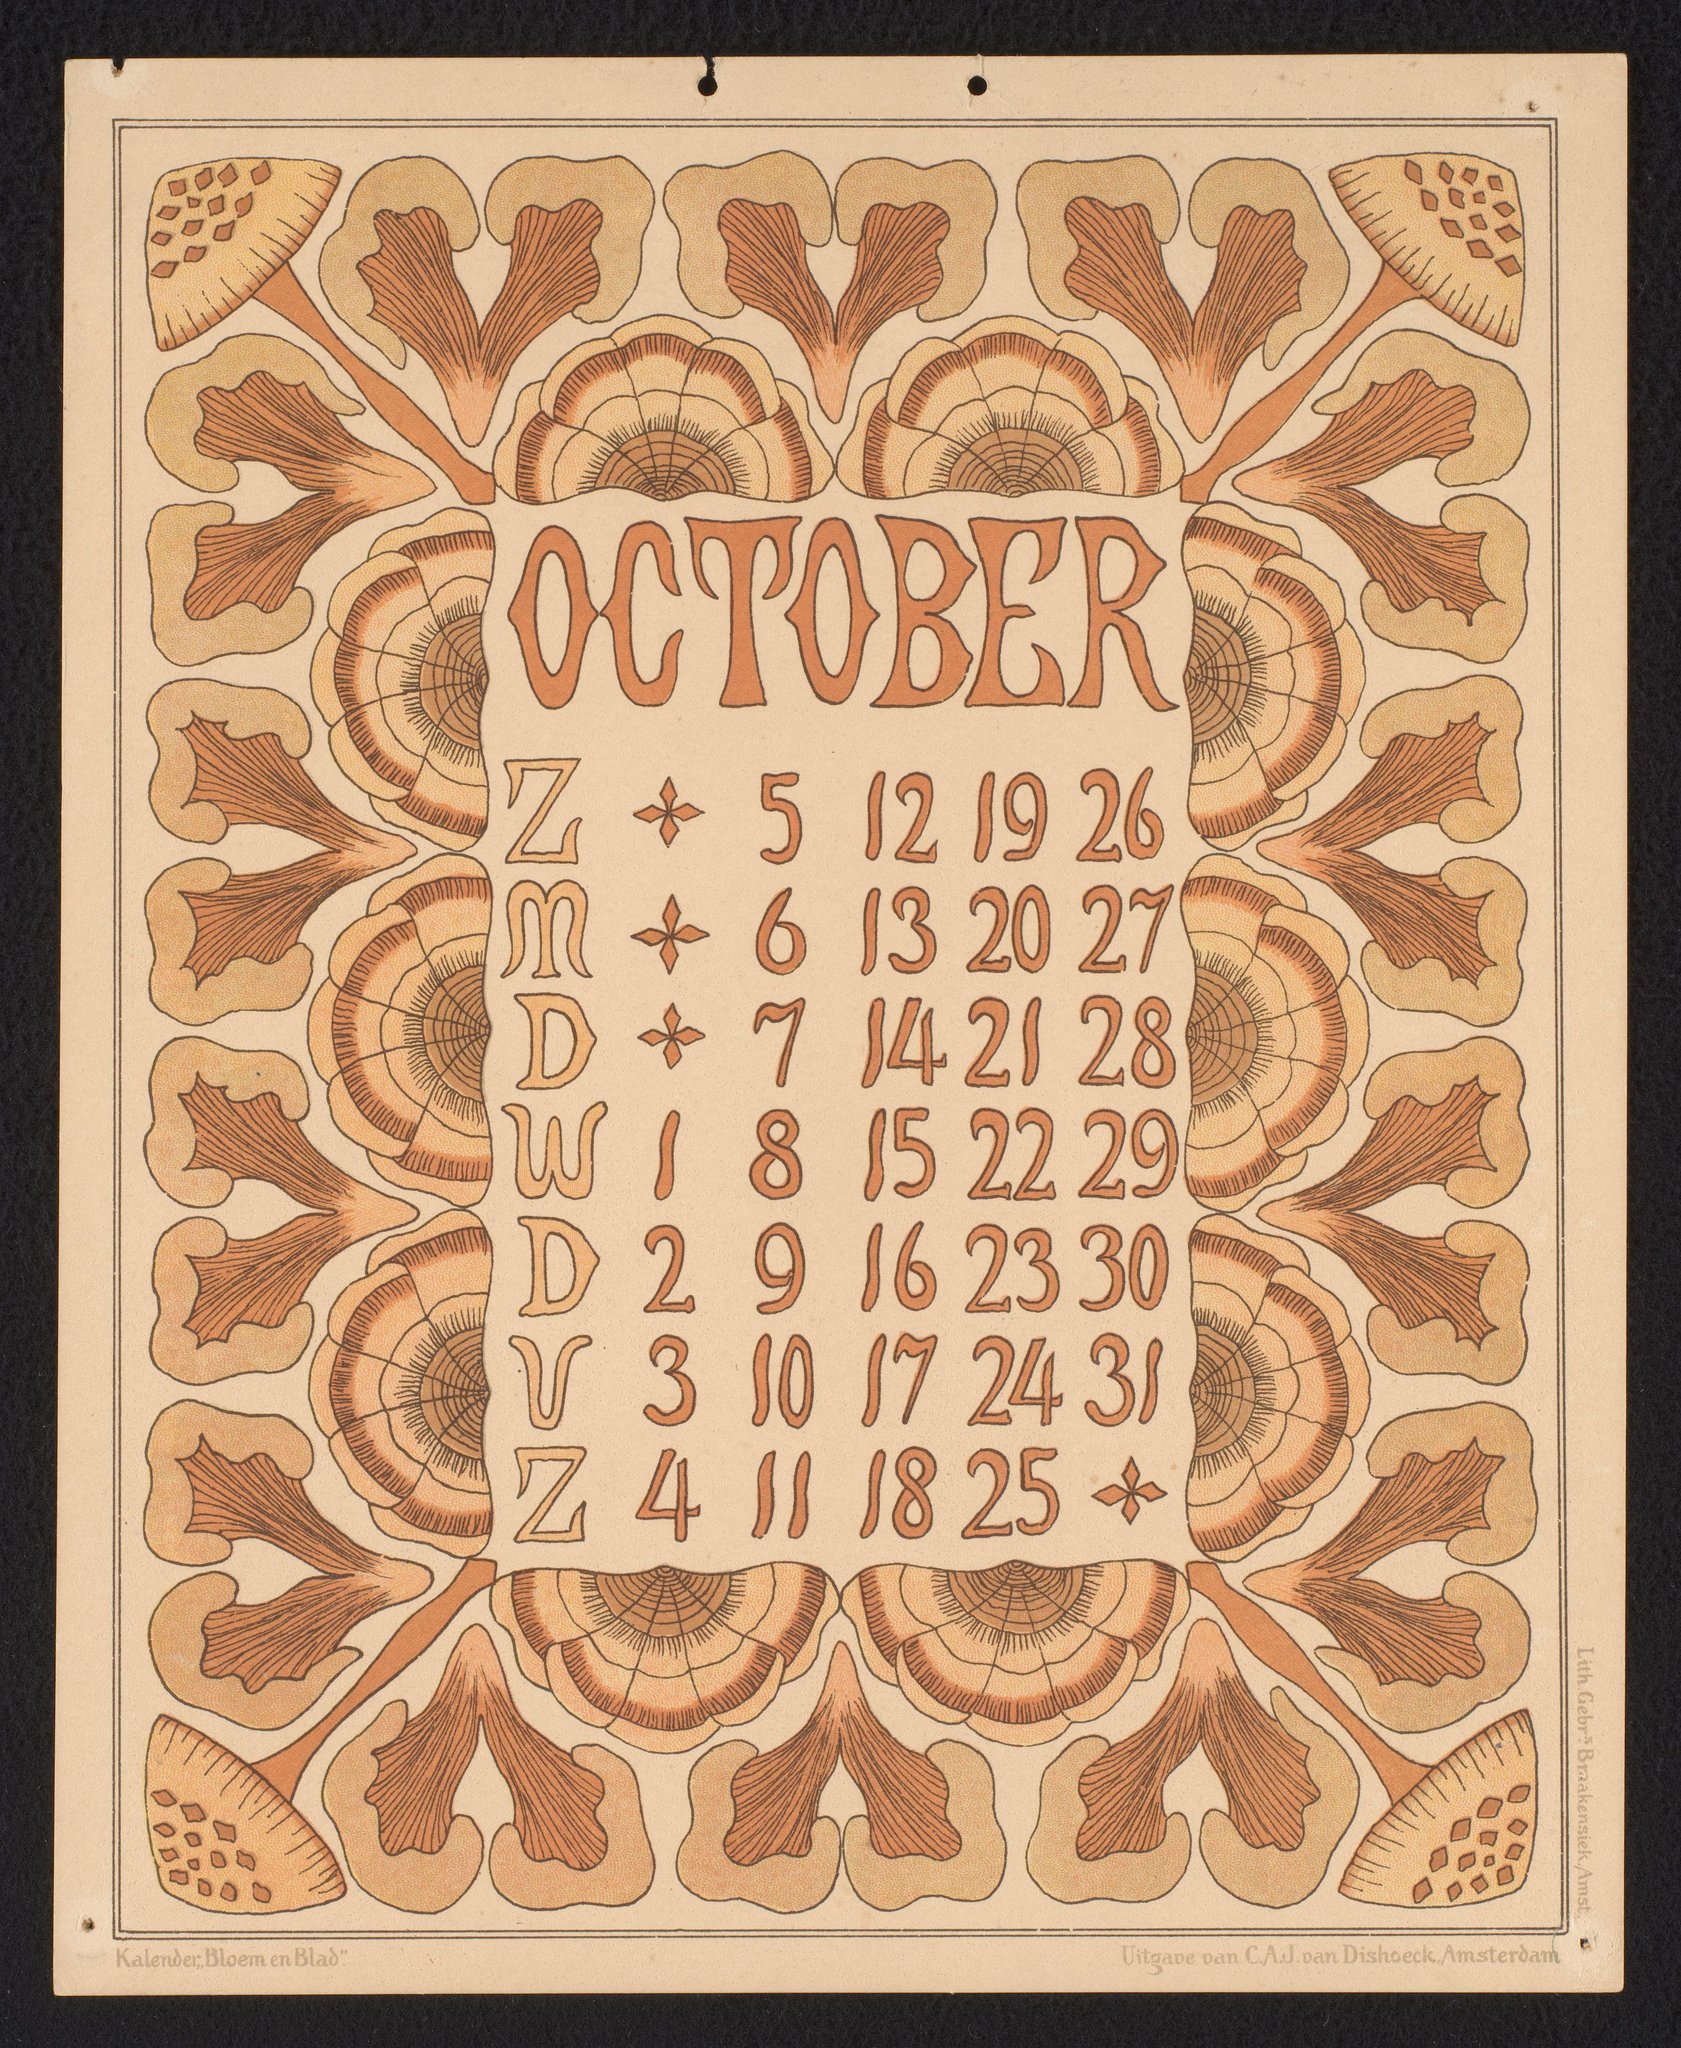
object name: calendar leaf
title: Kalenderblad voor oktober 1902 met paddenstoelen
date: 1901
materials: paper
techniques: lithograph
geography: amsterdam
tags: calendar, almanac, mushrooms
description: Decoratieve rand van paddenstoelen rond de maandkalender voor oktober. Kalender 'Bloem en Blad'.